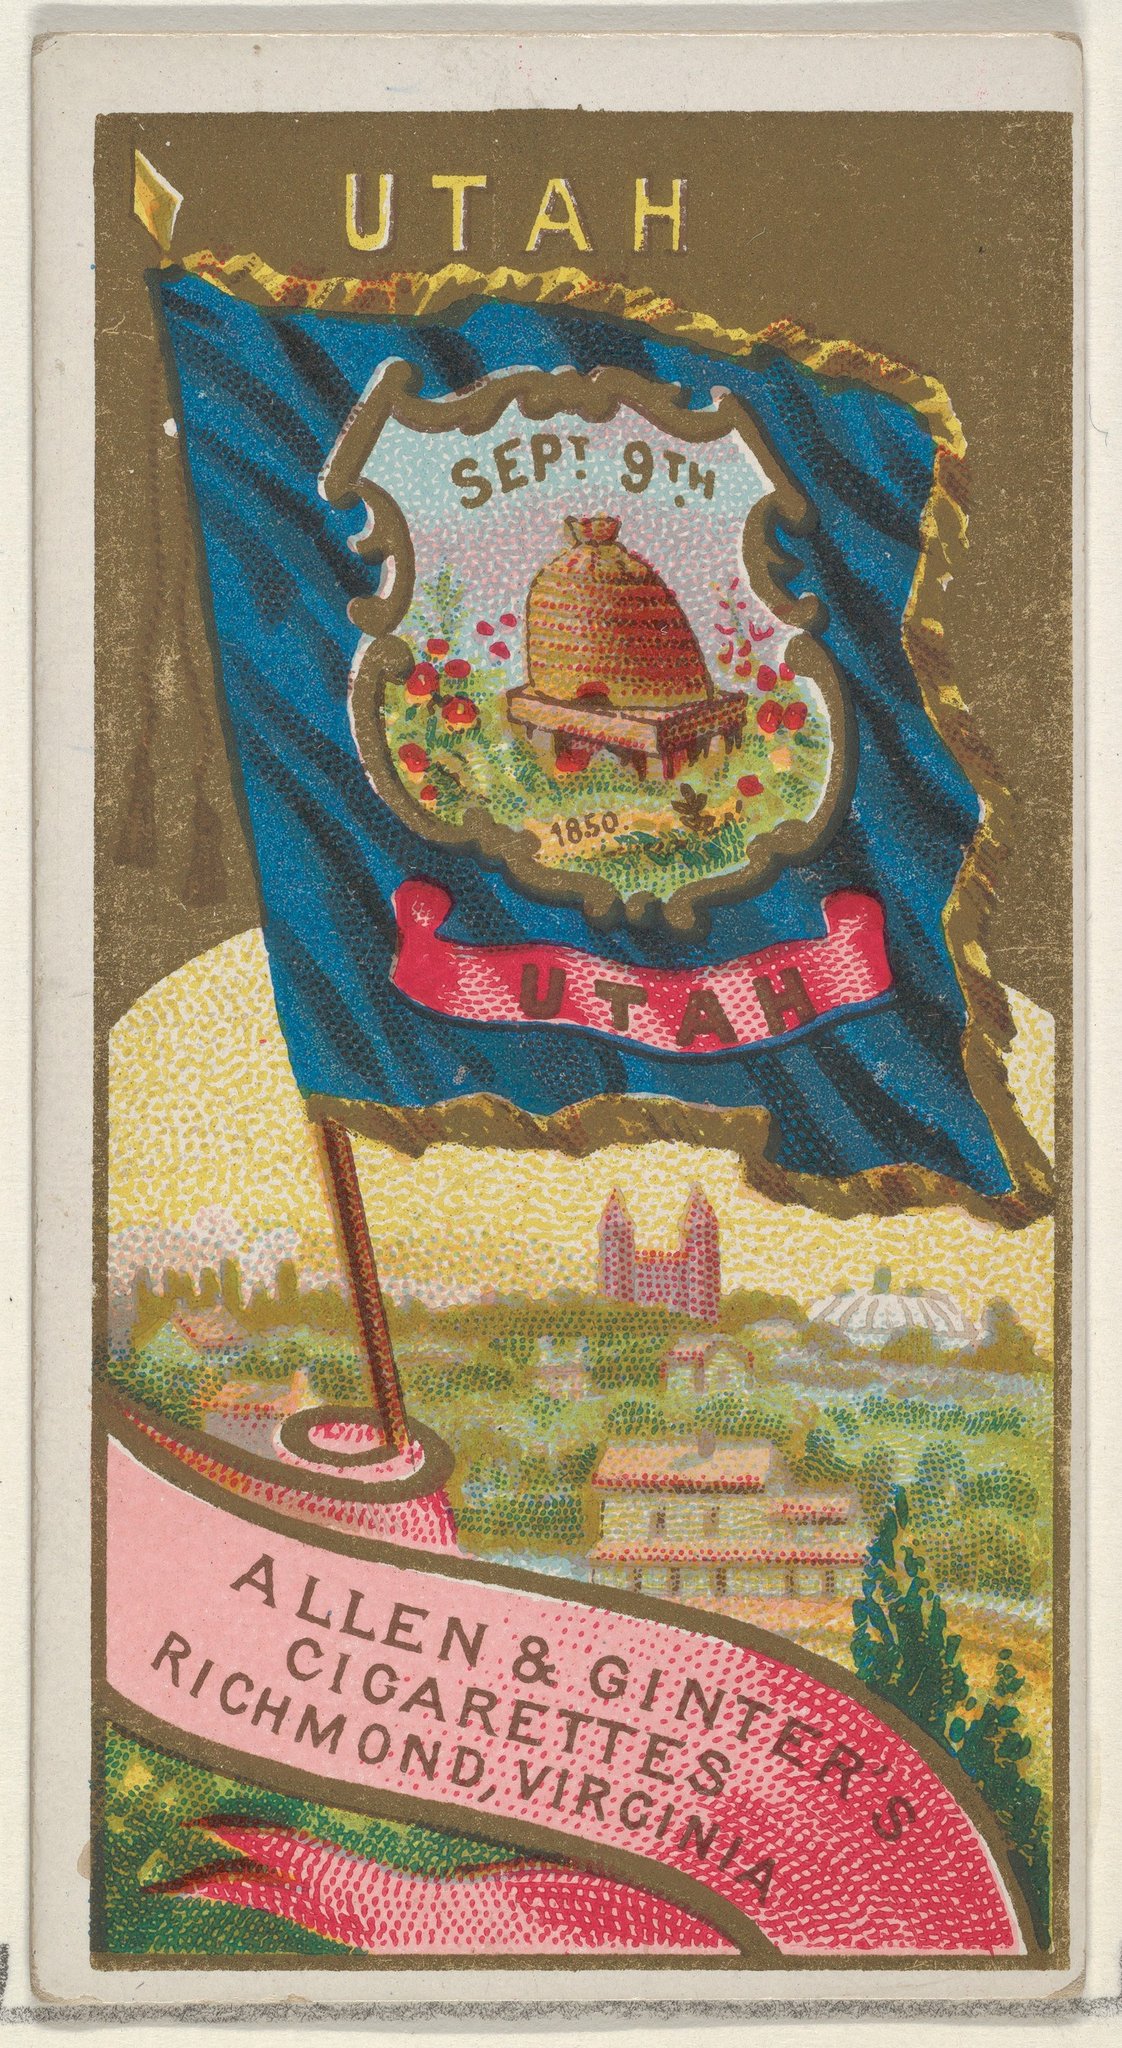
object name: print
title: Utah, from Flags of the States and Territories (N11) for Allen & Ginter Cigarettes Brands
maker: allen & ginter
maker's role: publisher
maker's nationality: american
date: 1888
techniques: color lithograph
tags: flags